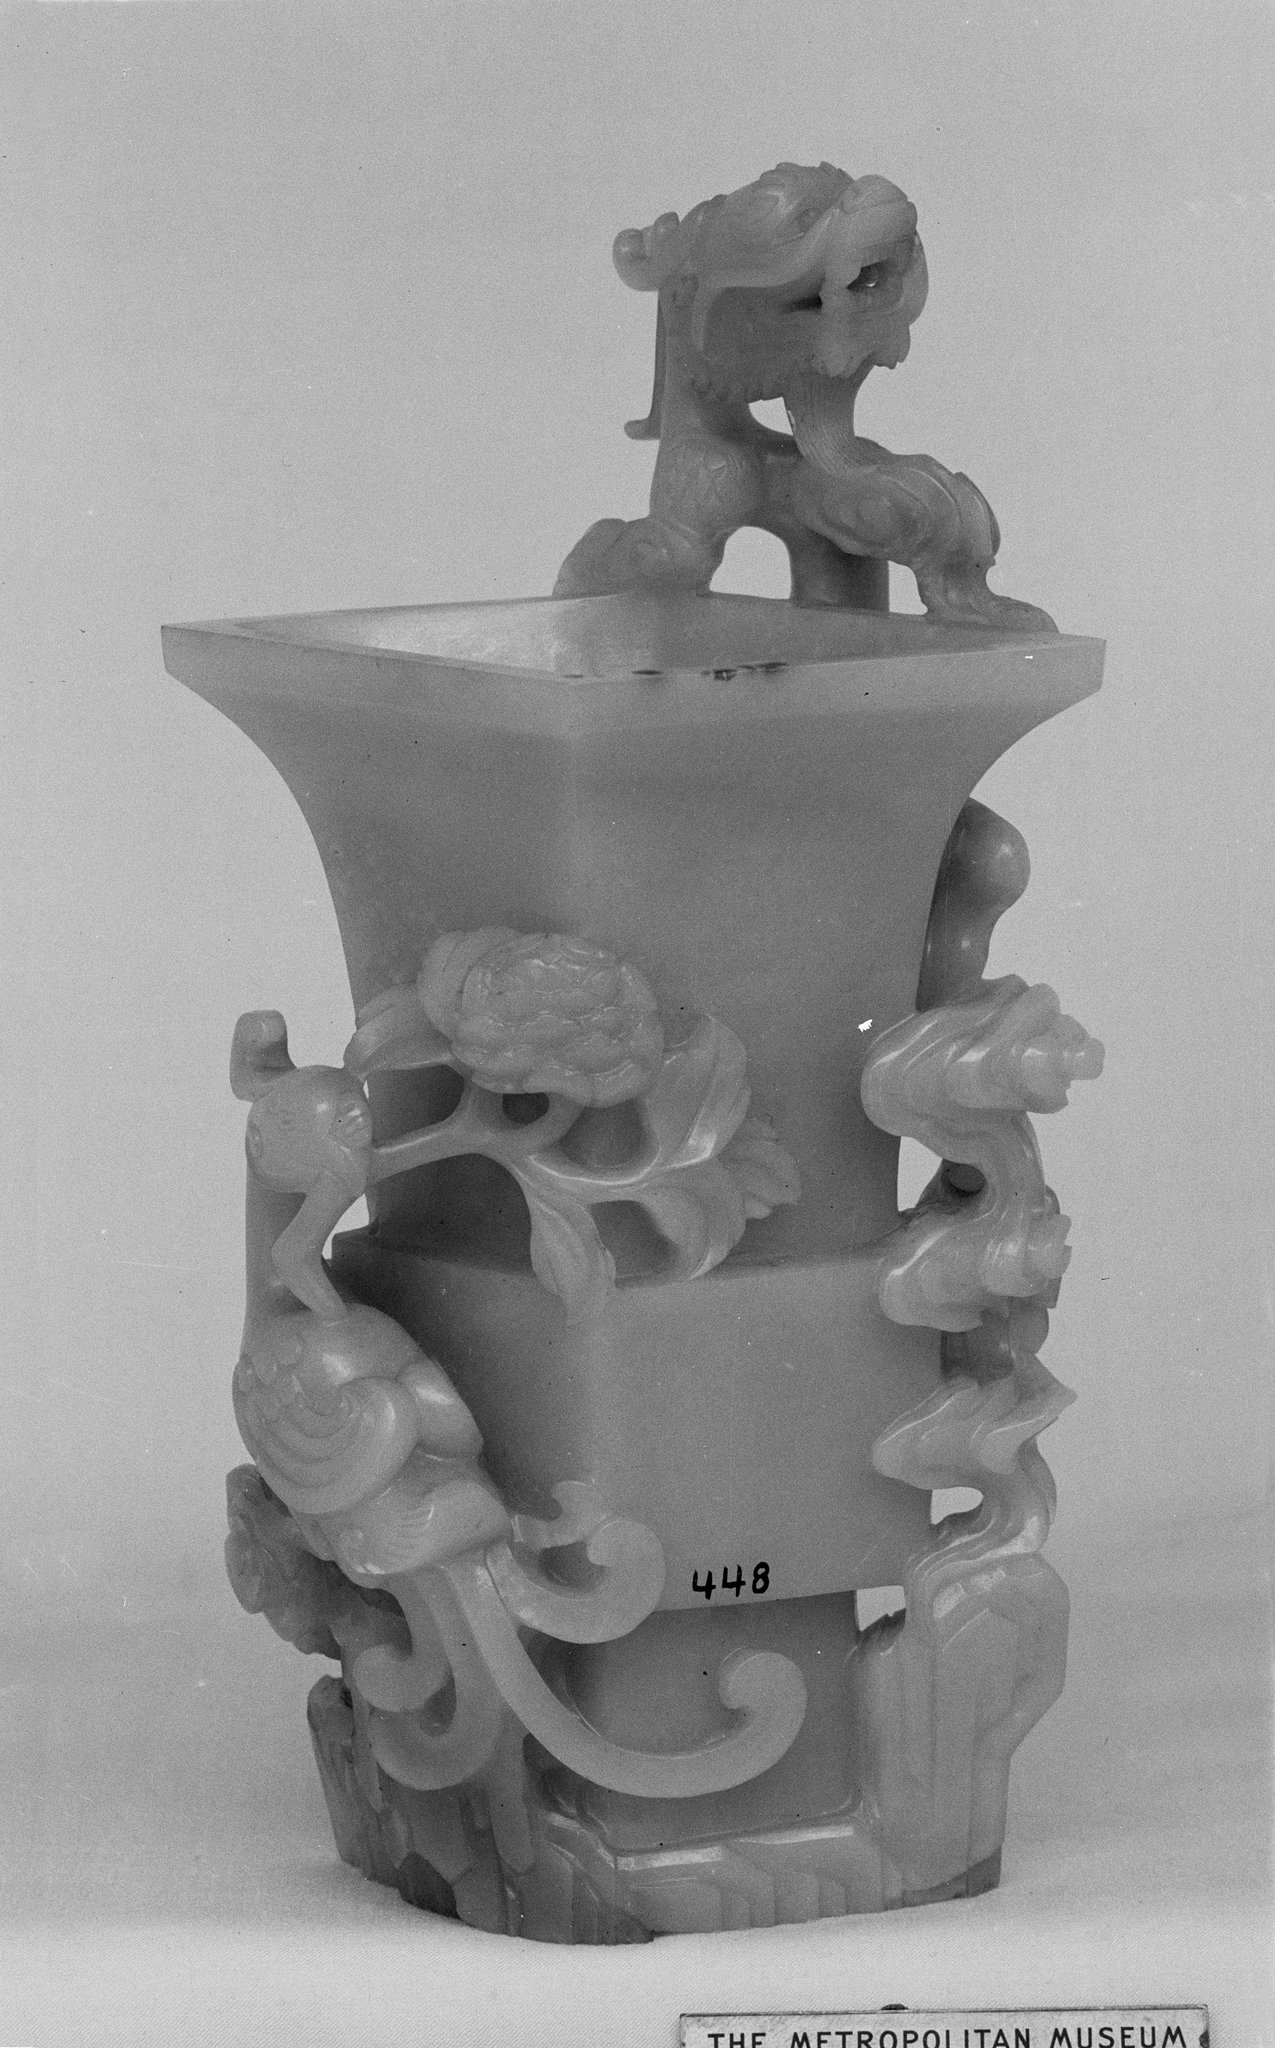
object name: vase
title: Beaker-Shaped Vase with Dragon and Phoenix (Hua Gu)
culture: chinese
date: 1662-1722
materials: jade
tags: dragons,flowers